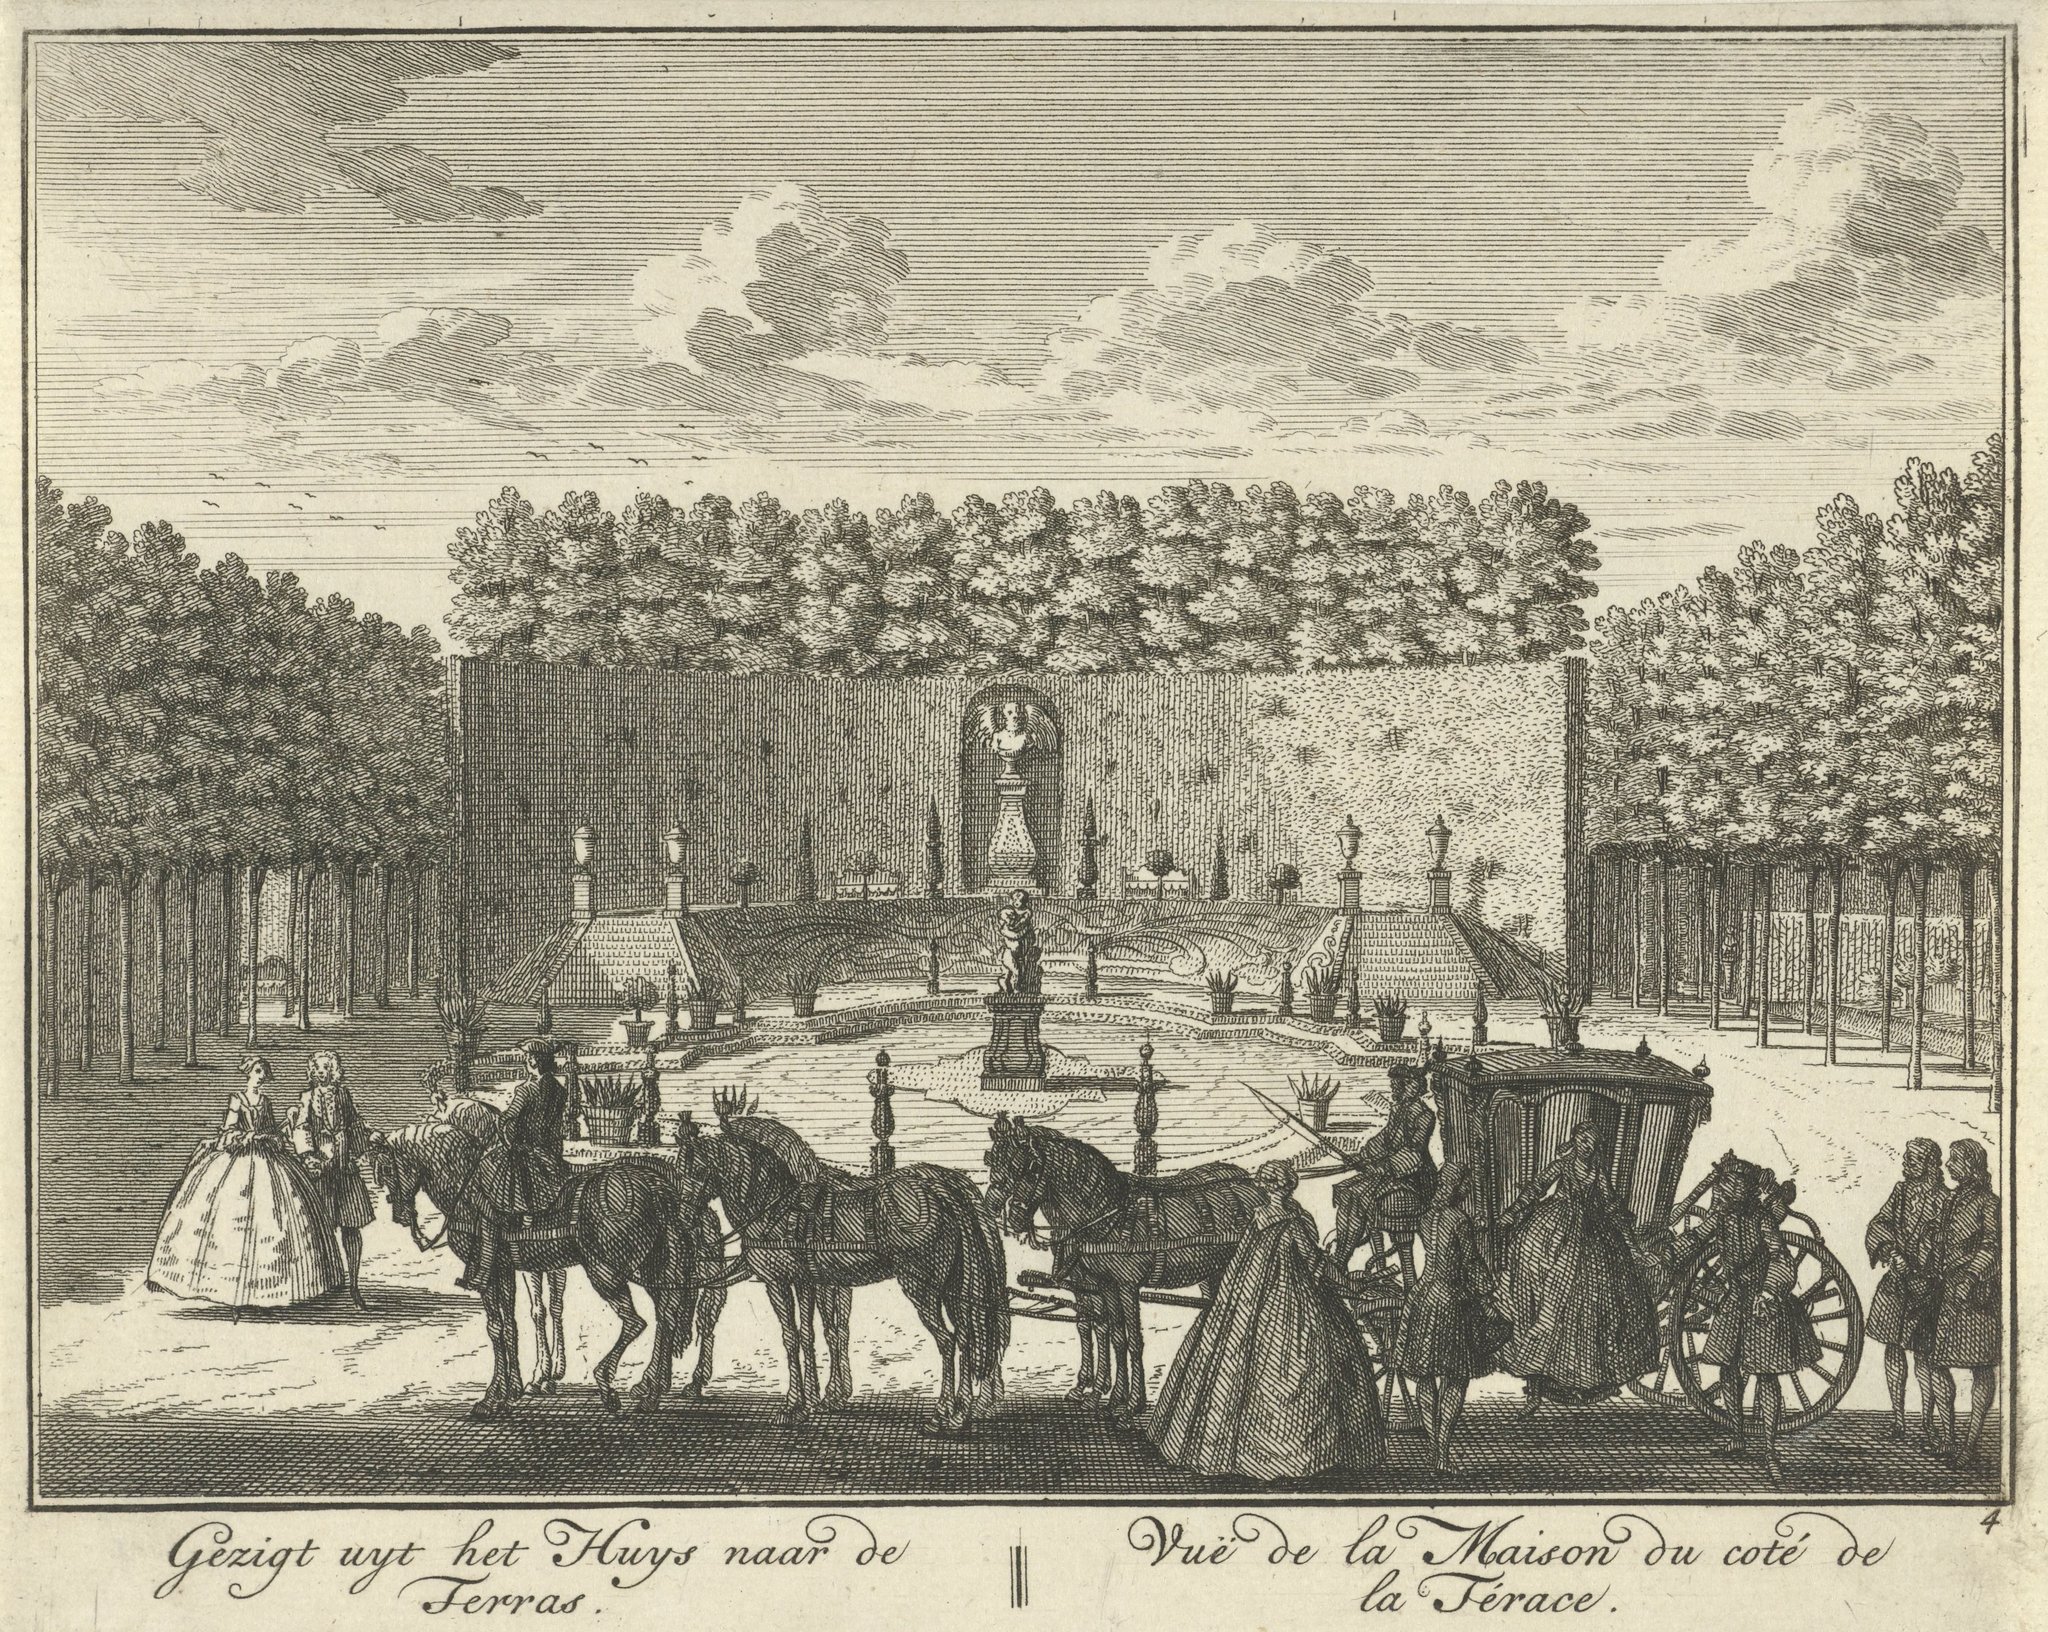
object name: print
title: Het Oud Adelyk huys en Ridderhofstad Ter Meer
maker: hendrik de leth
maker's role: draughtsman, print maker, publisher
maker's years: 1703-1766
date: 1740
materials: paper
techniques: etching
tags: french or architectonic garden; formal garden, country-house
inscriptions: collector's mark: Lugt 2228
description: Gezicht op het terras in de Franse tuin van Huis ter Meer te Maarssen. Op de voorgrond staat een koets met zes paarden, rondom kijken figuren toe. De prent maakt deel uit van een serie met 26 gezichten op Huis ter Meer en het bijbehorende landgoed te Maarssen.